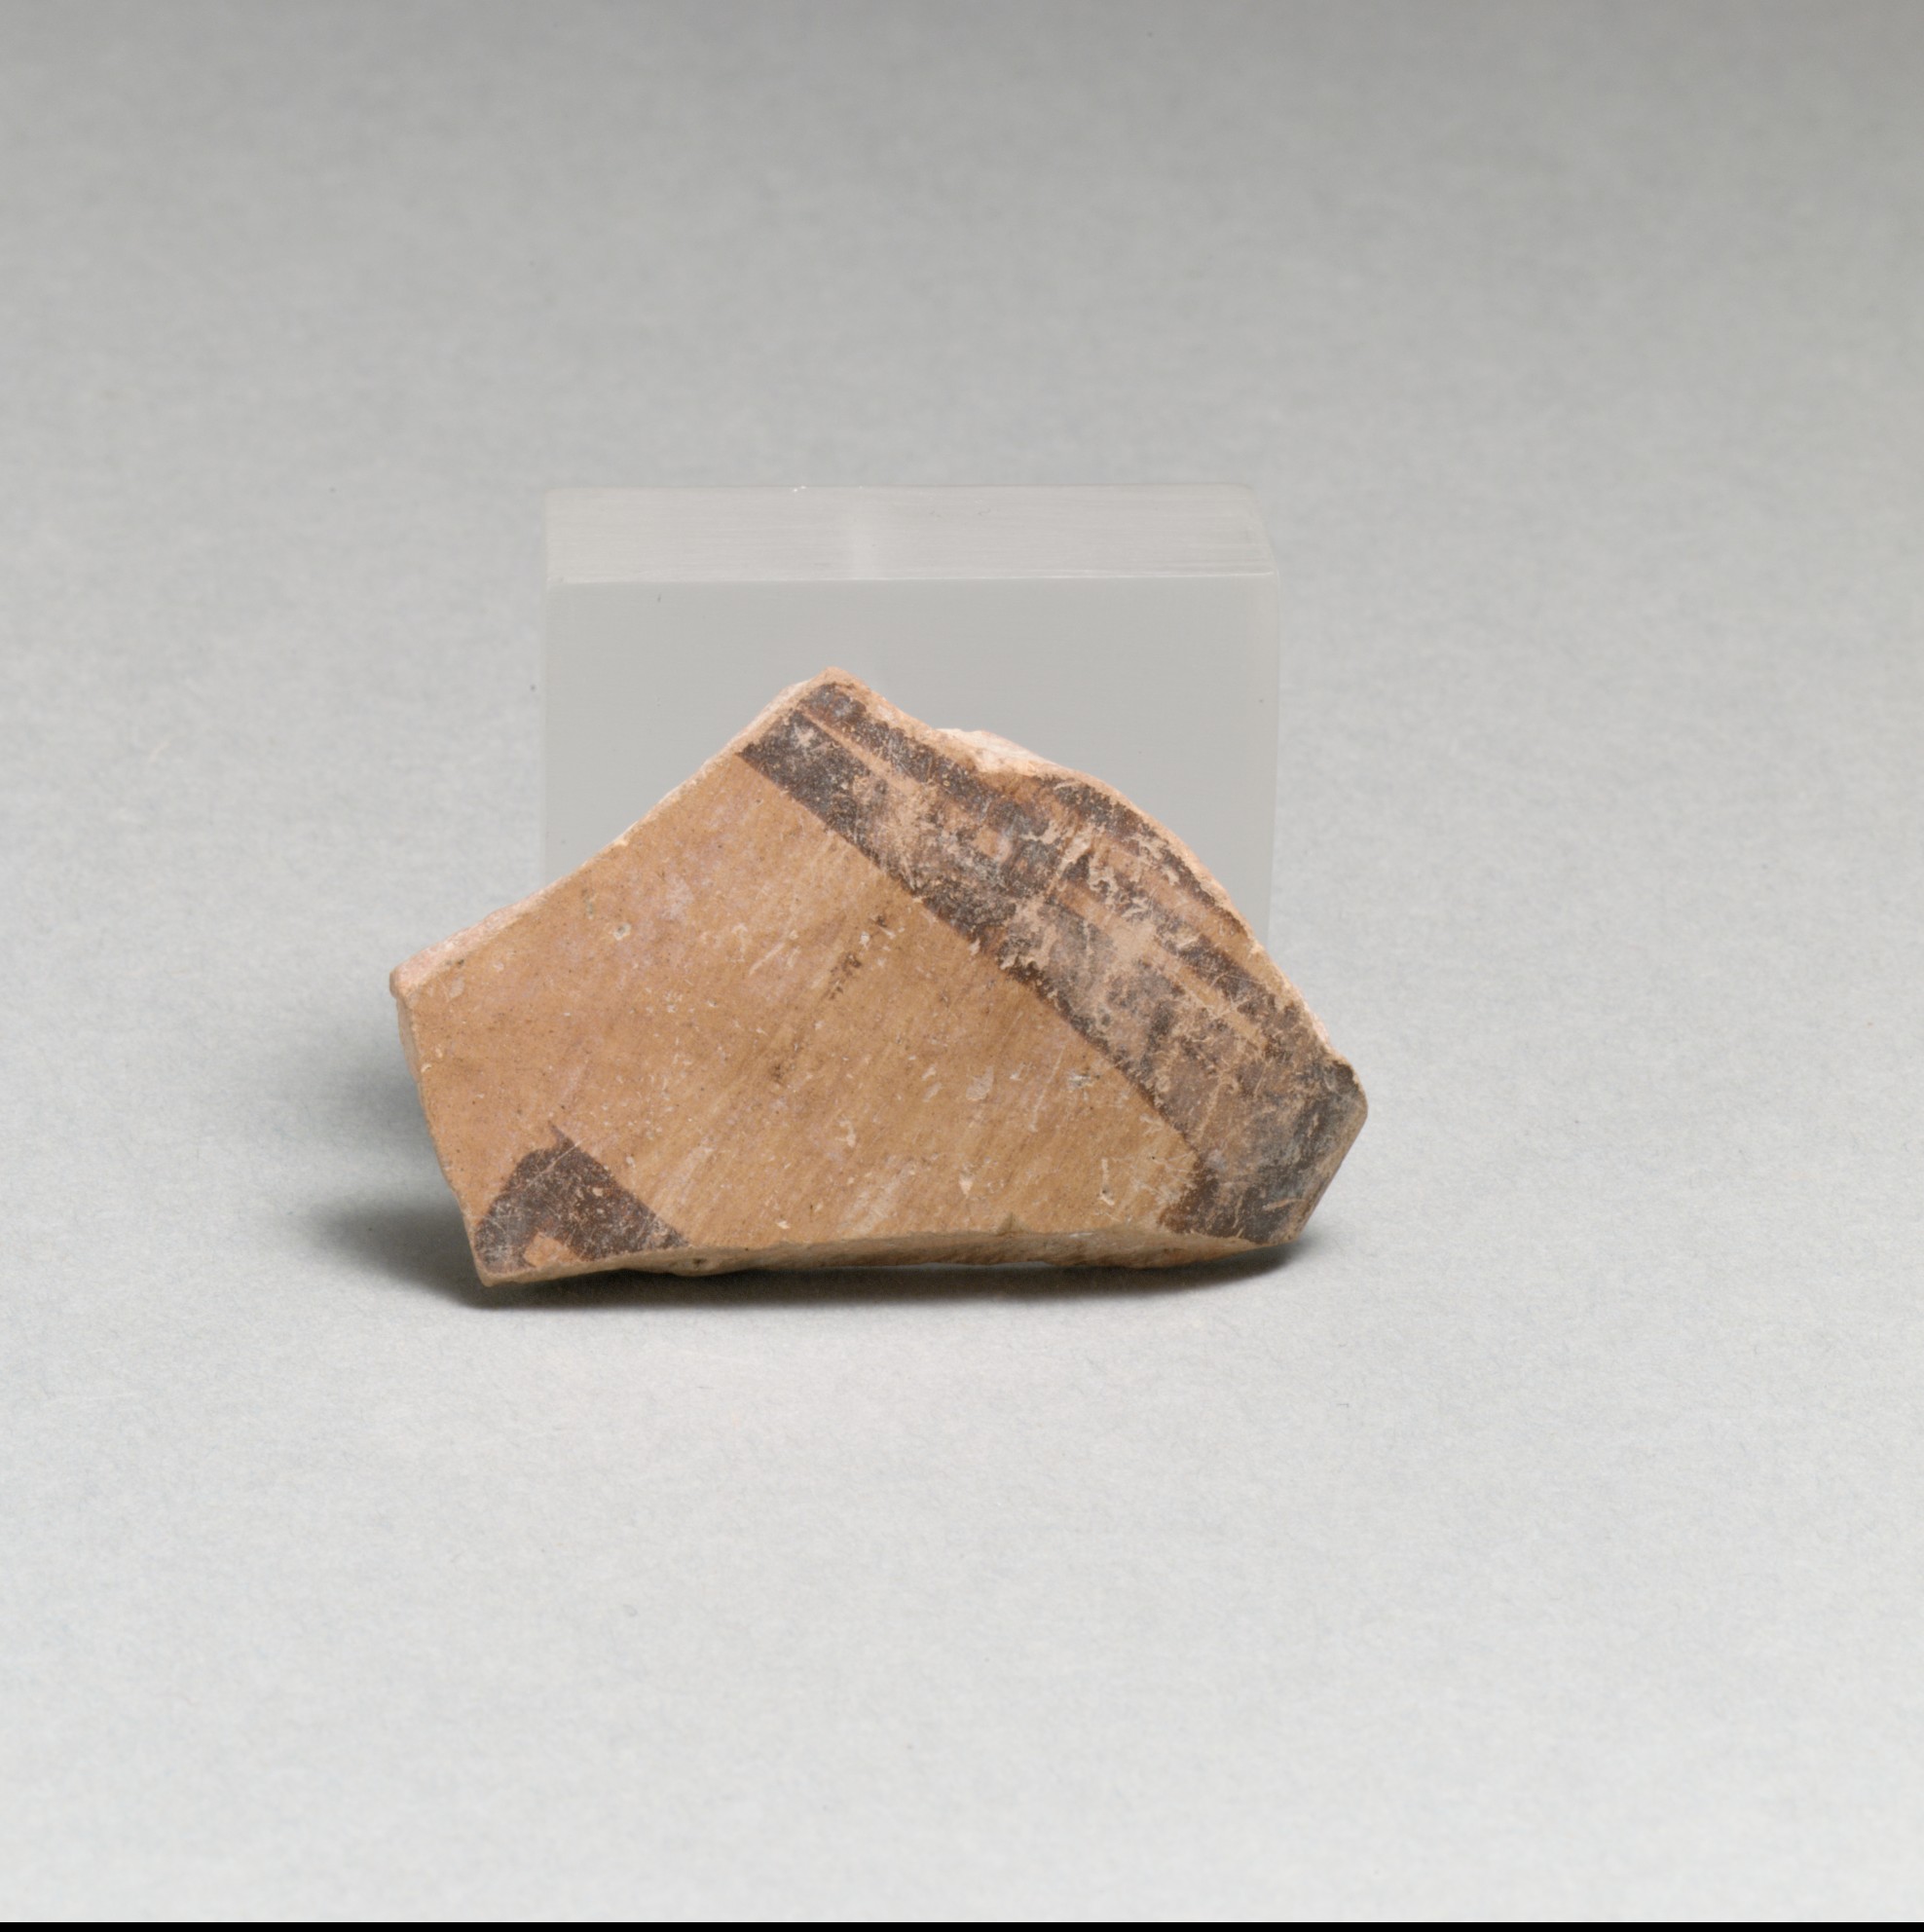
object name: vase fragment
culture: neolithic, thessaly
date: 4000-3000 BCE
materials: terracotta